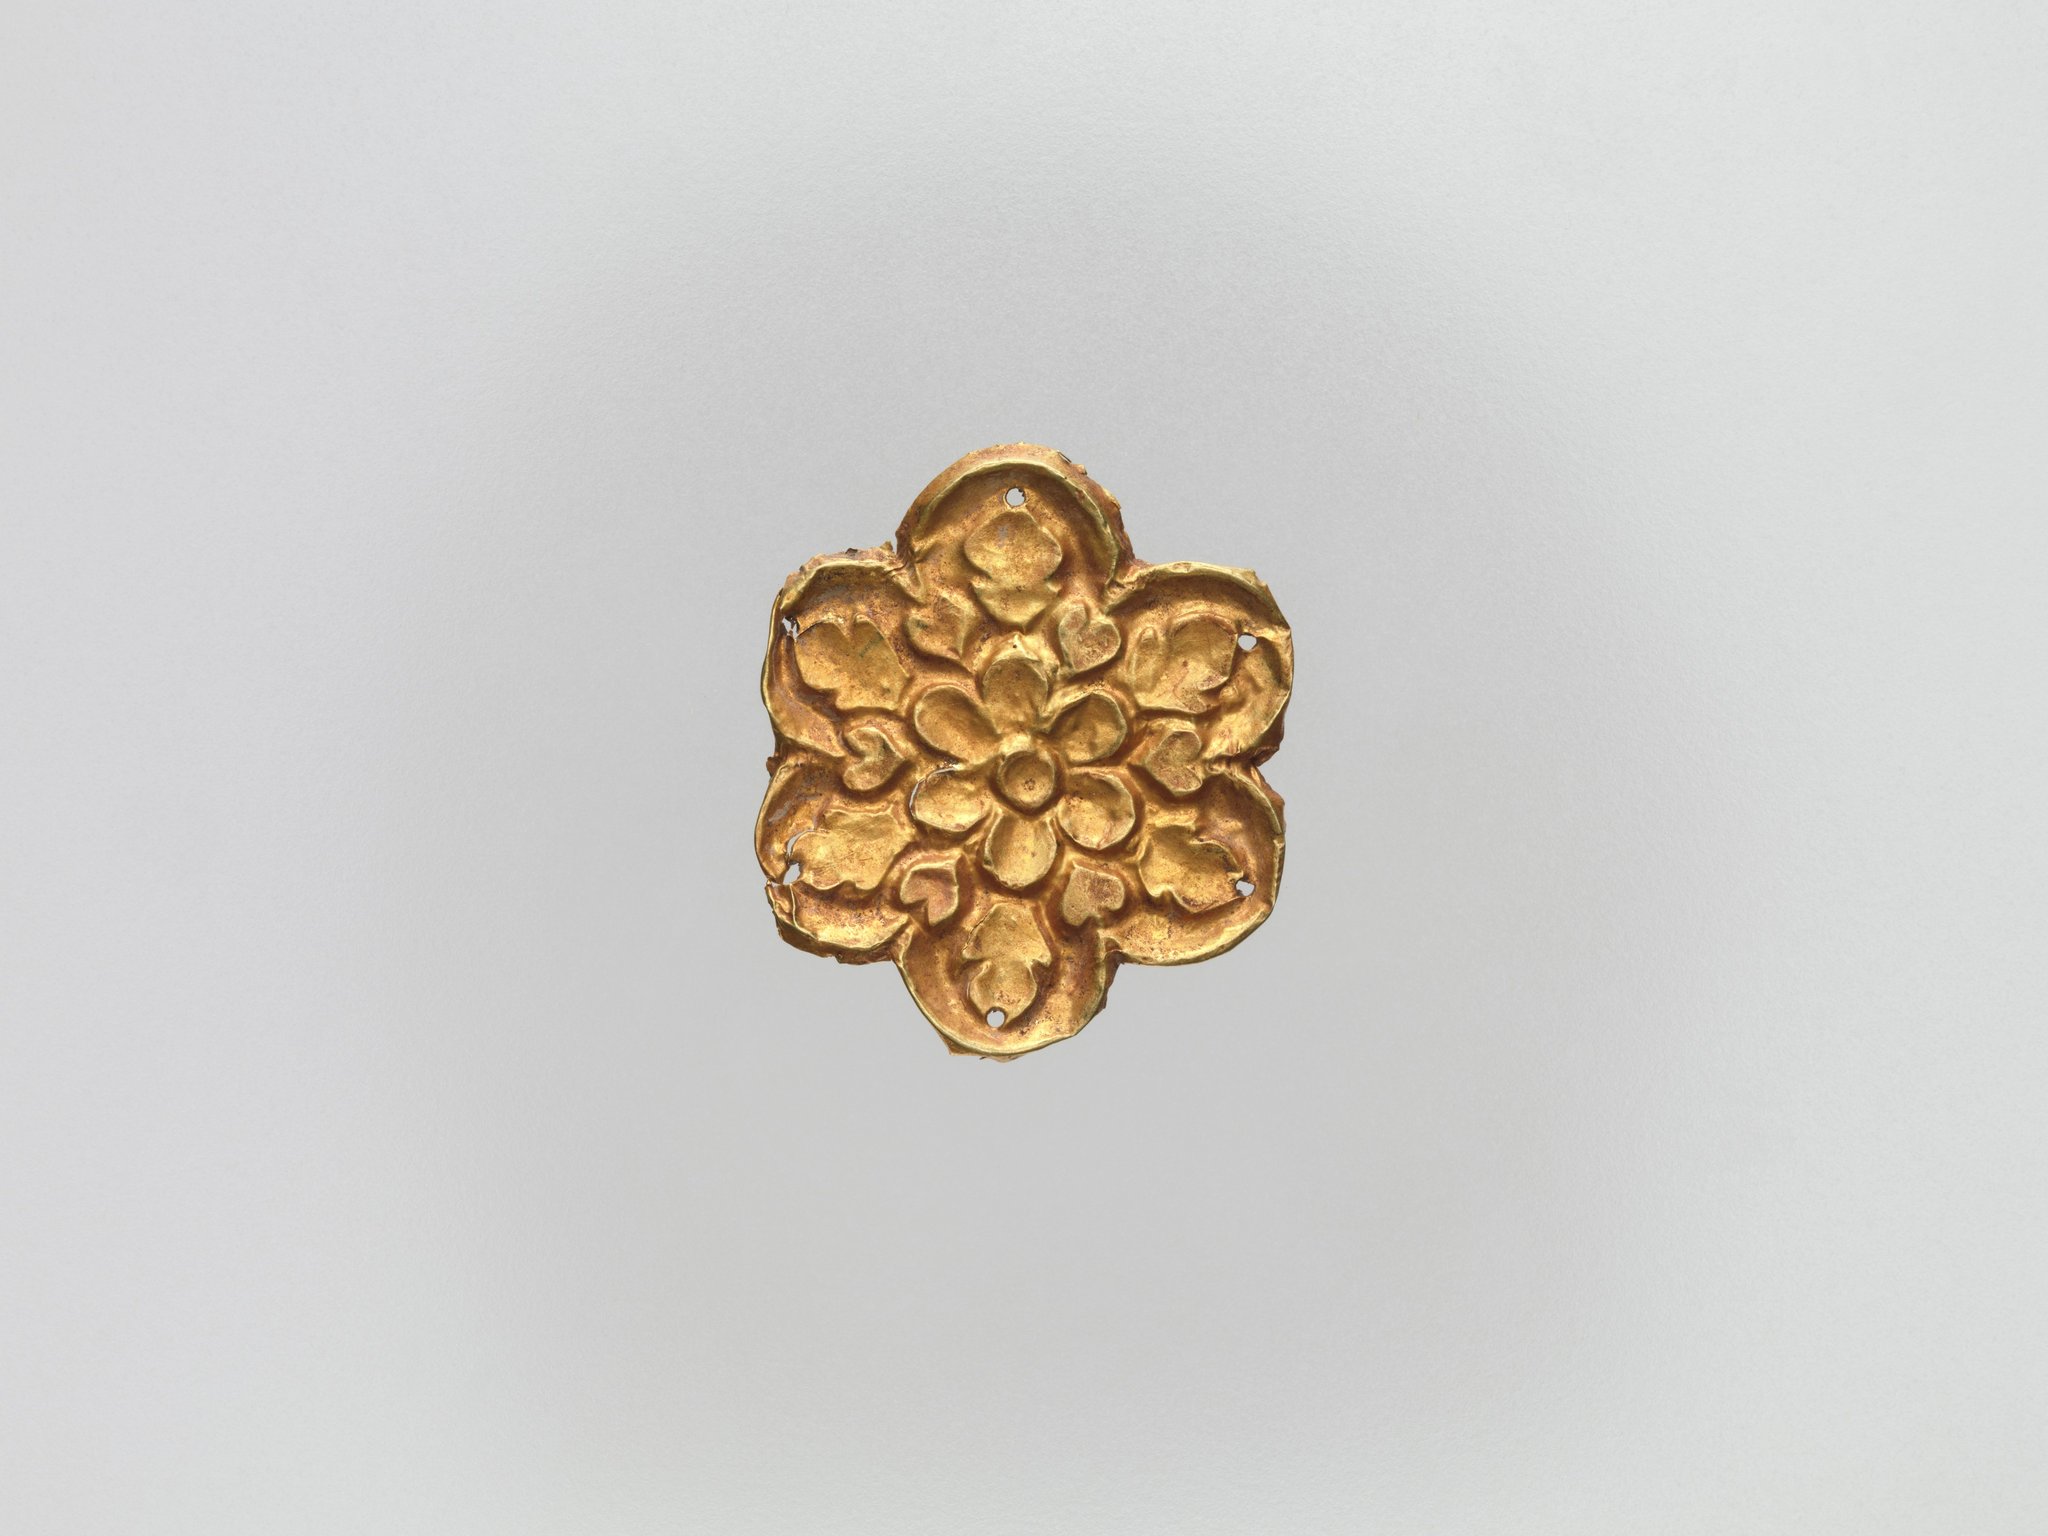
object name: garment plaque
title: Flower-Shaped Clothing Plaque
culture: chinese or central asian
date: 601-900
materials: gold